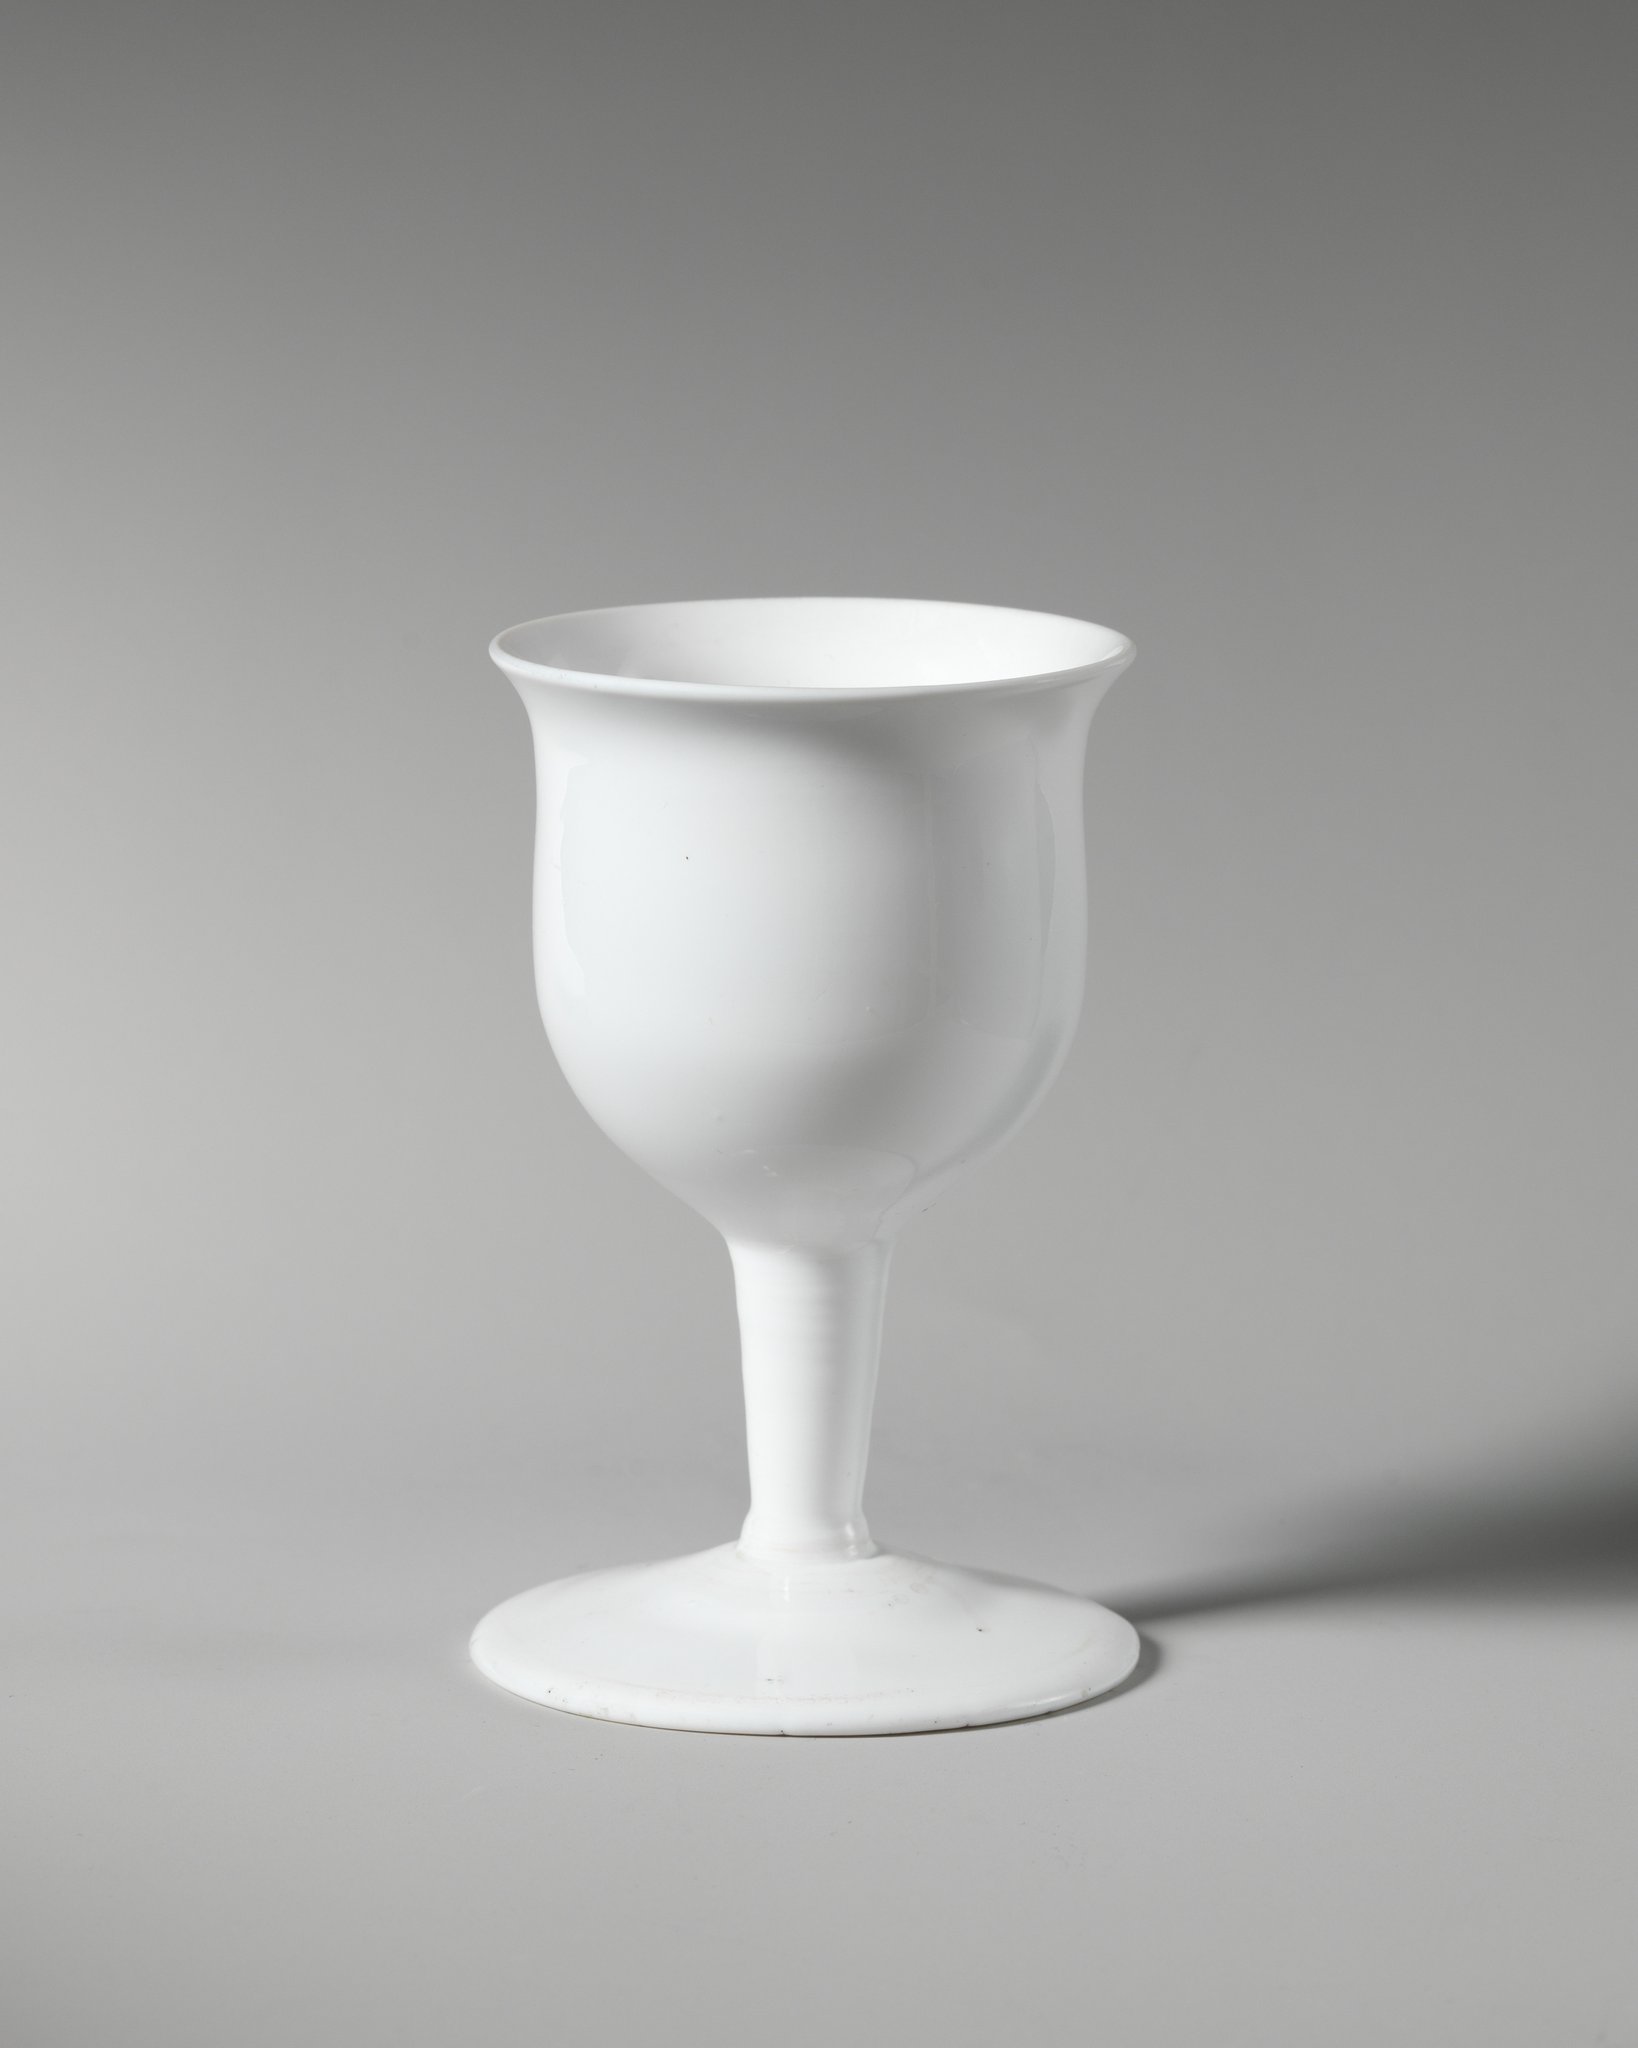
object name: egg cup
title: Egg cup (one of a pair)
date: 1750-1800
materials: glass